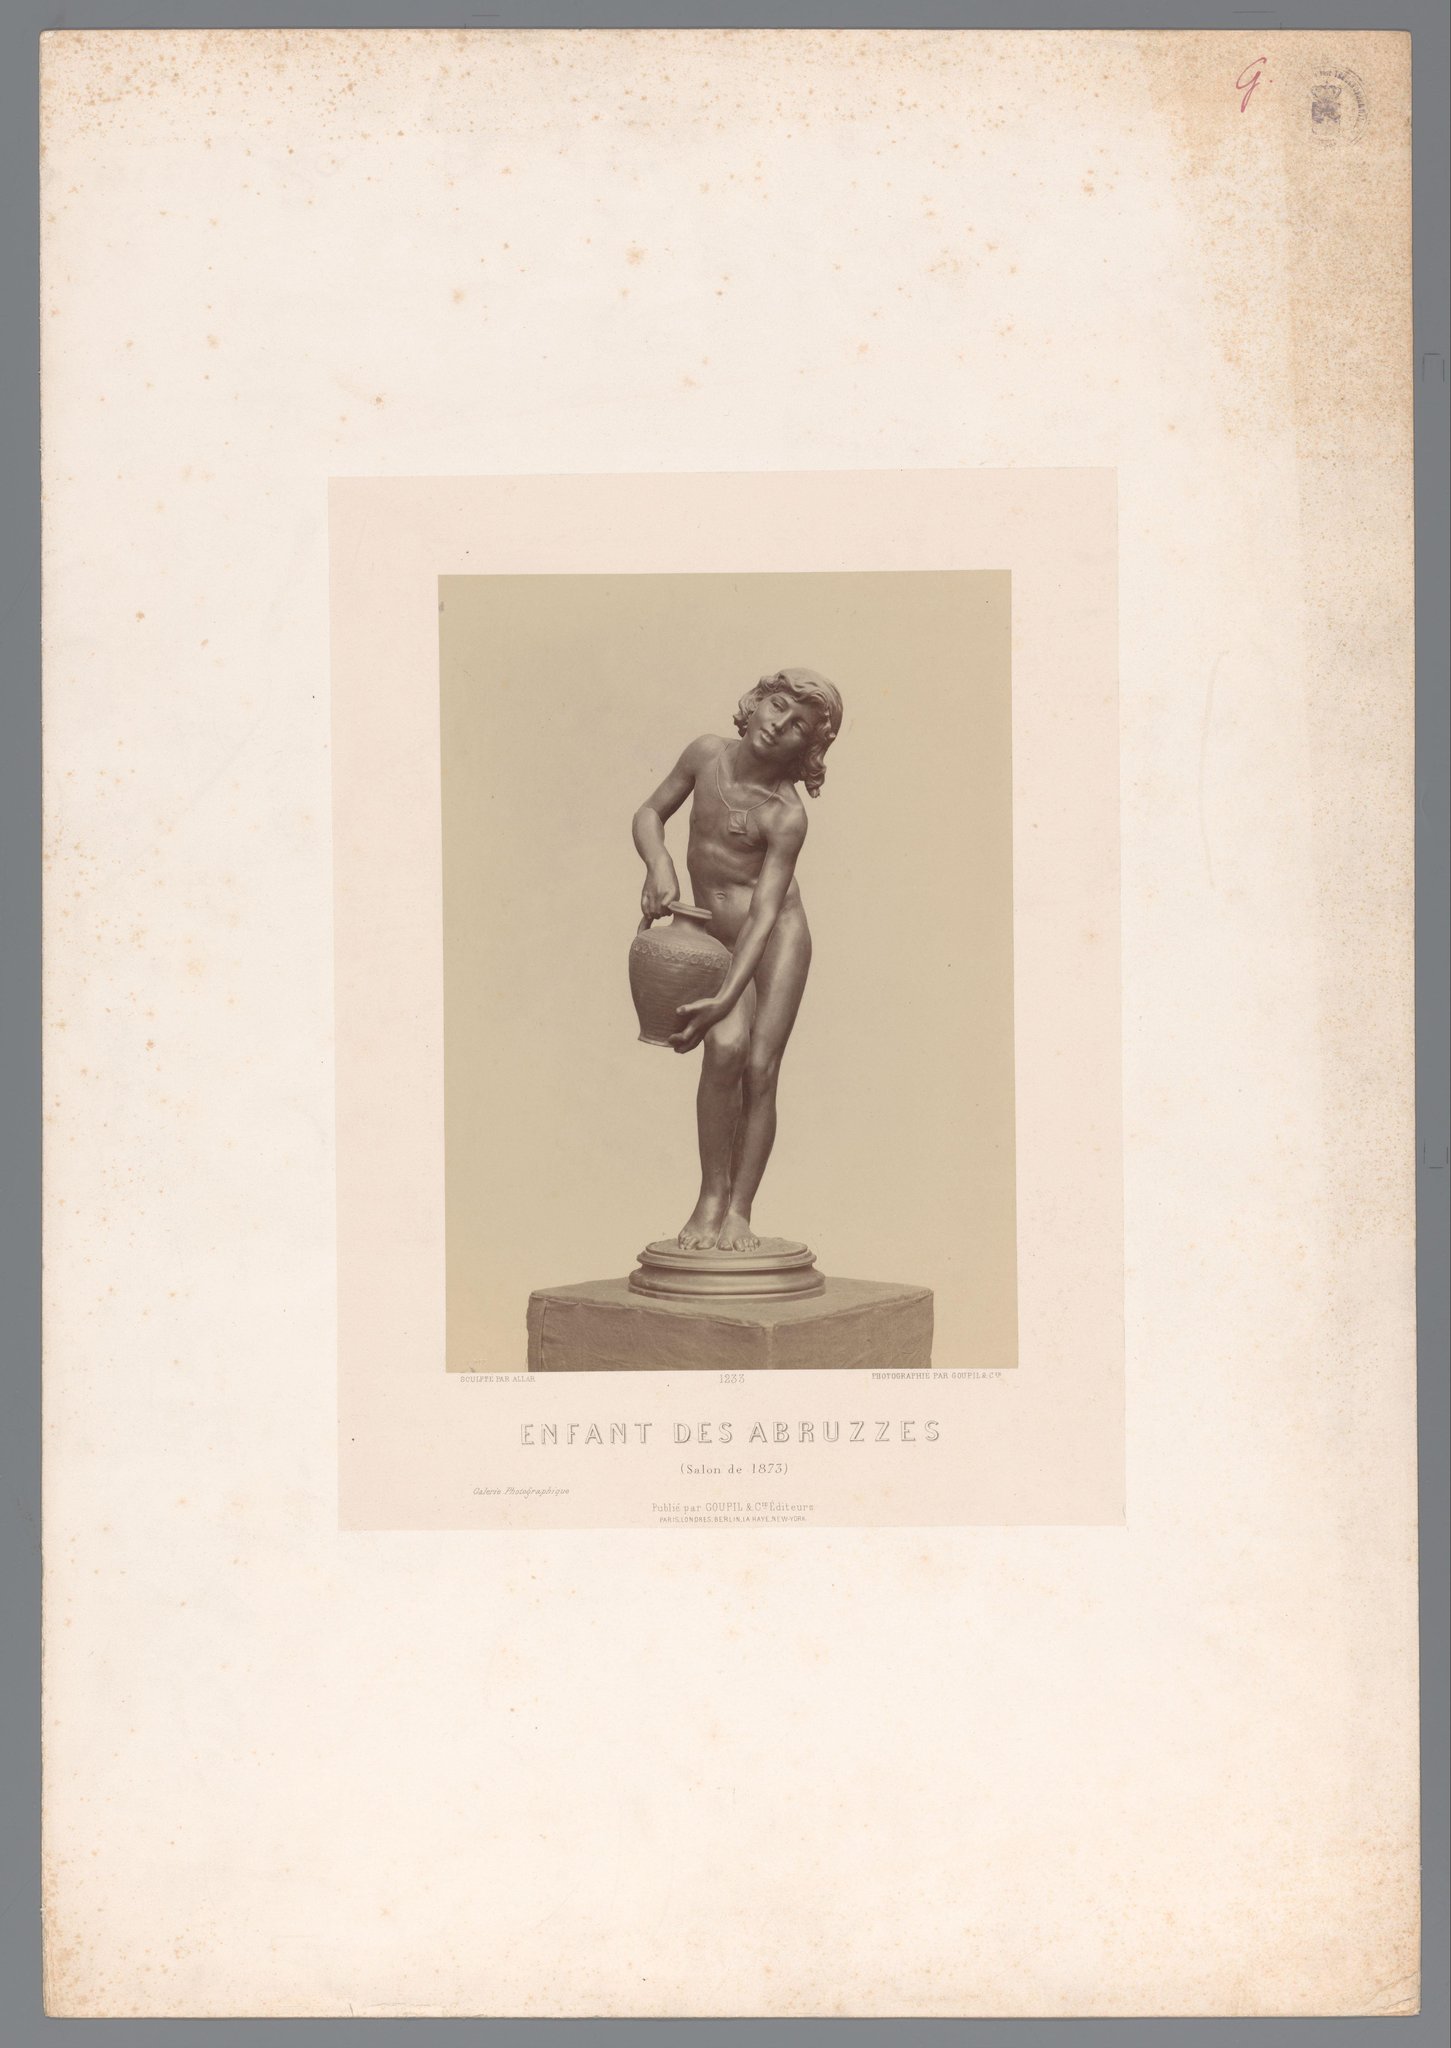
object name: photograph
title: Enfant des Abruzzes (Salon de 1873)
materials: cardboard, paper, photographic support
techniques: albumen print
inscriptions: stamp, : ‘G’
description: Sculptuur door Allar van een staande naakte jongeling met een kruik.